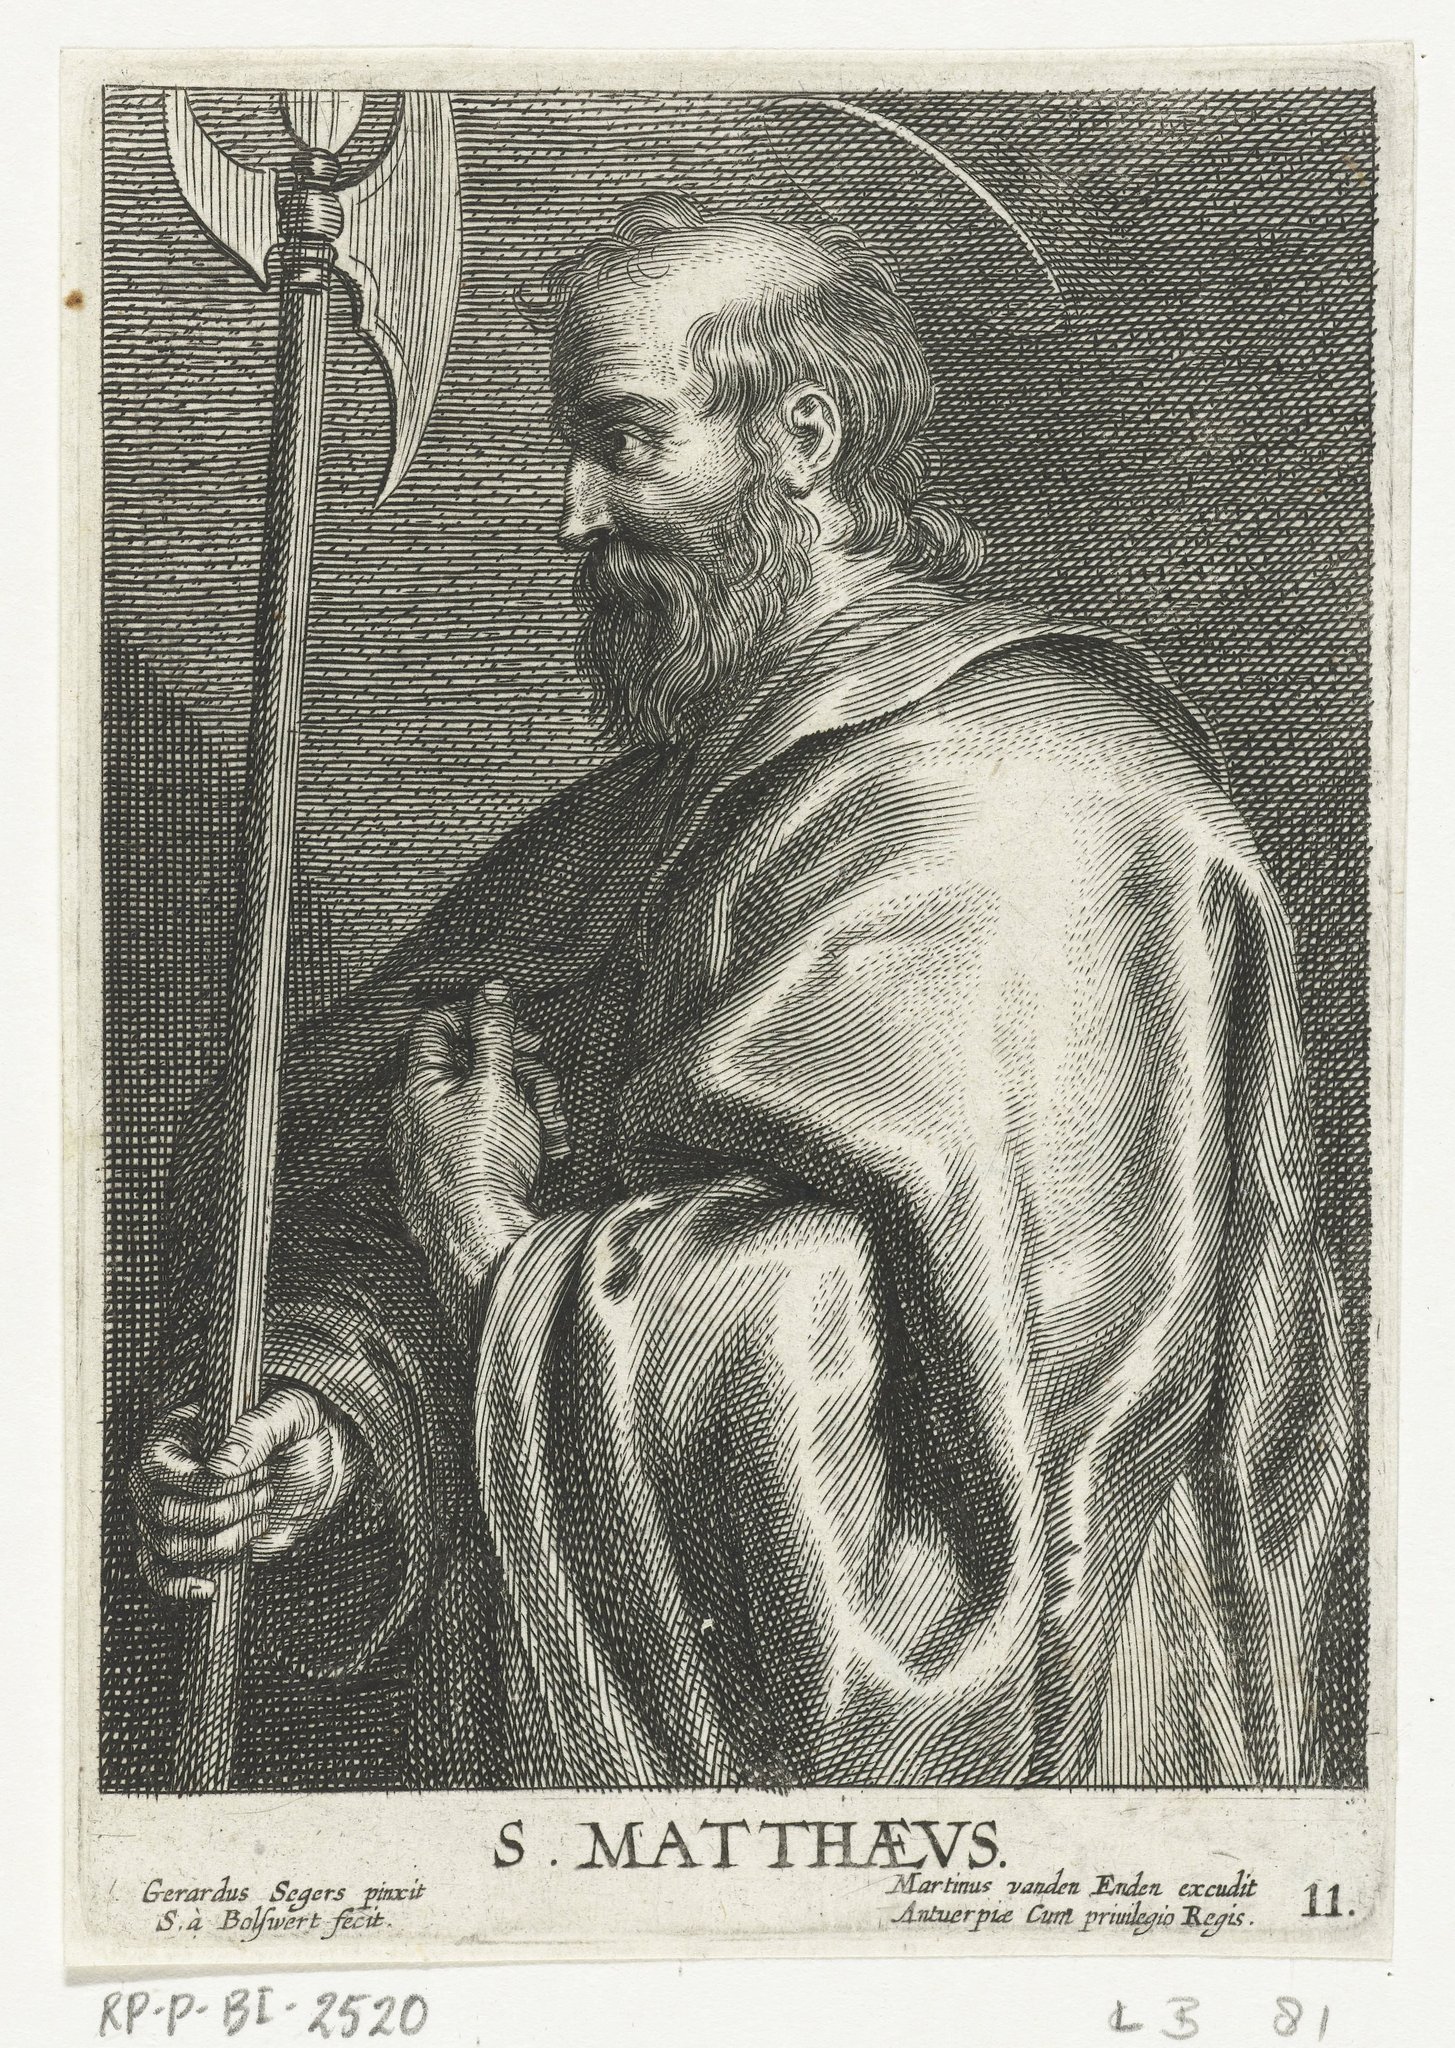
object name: print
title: Heilige Matteüs met hellebaard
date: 1596-1659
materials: paper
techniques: engraving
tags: the apostle and evangelist matthew (mattheus); possible attributes: angel, axe, book, halberd, pen and inkhorn, purse, scroll, square, sword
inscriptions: collector's mark: Lugt 240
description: Prent uit serie met veertien prenten met Christus, Paulus en twaalf apostelen naar ontwerp van Gerard Seghers.